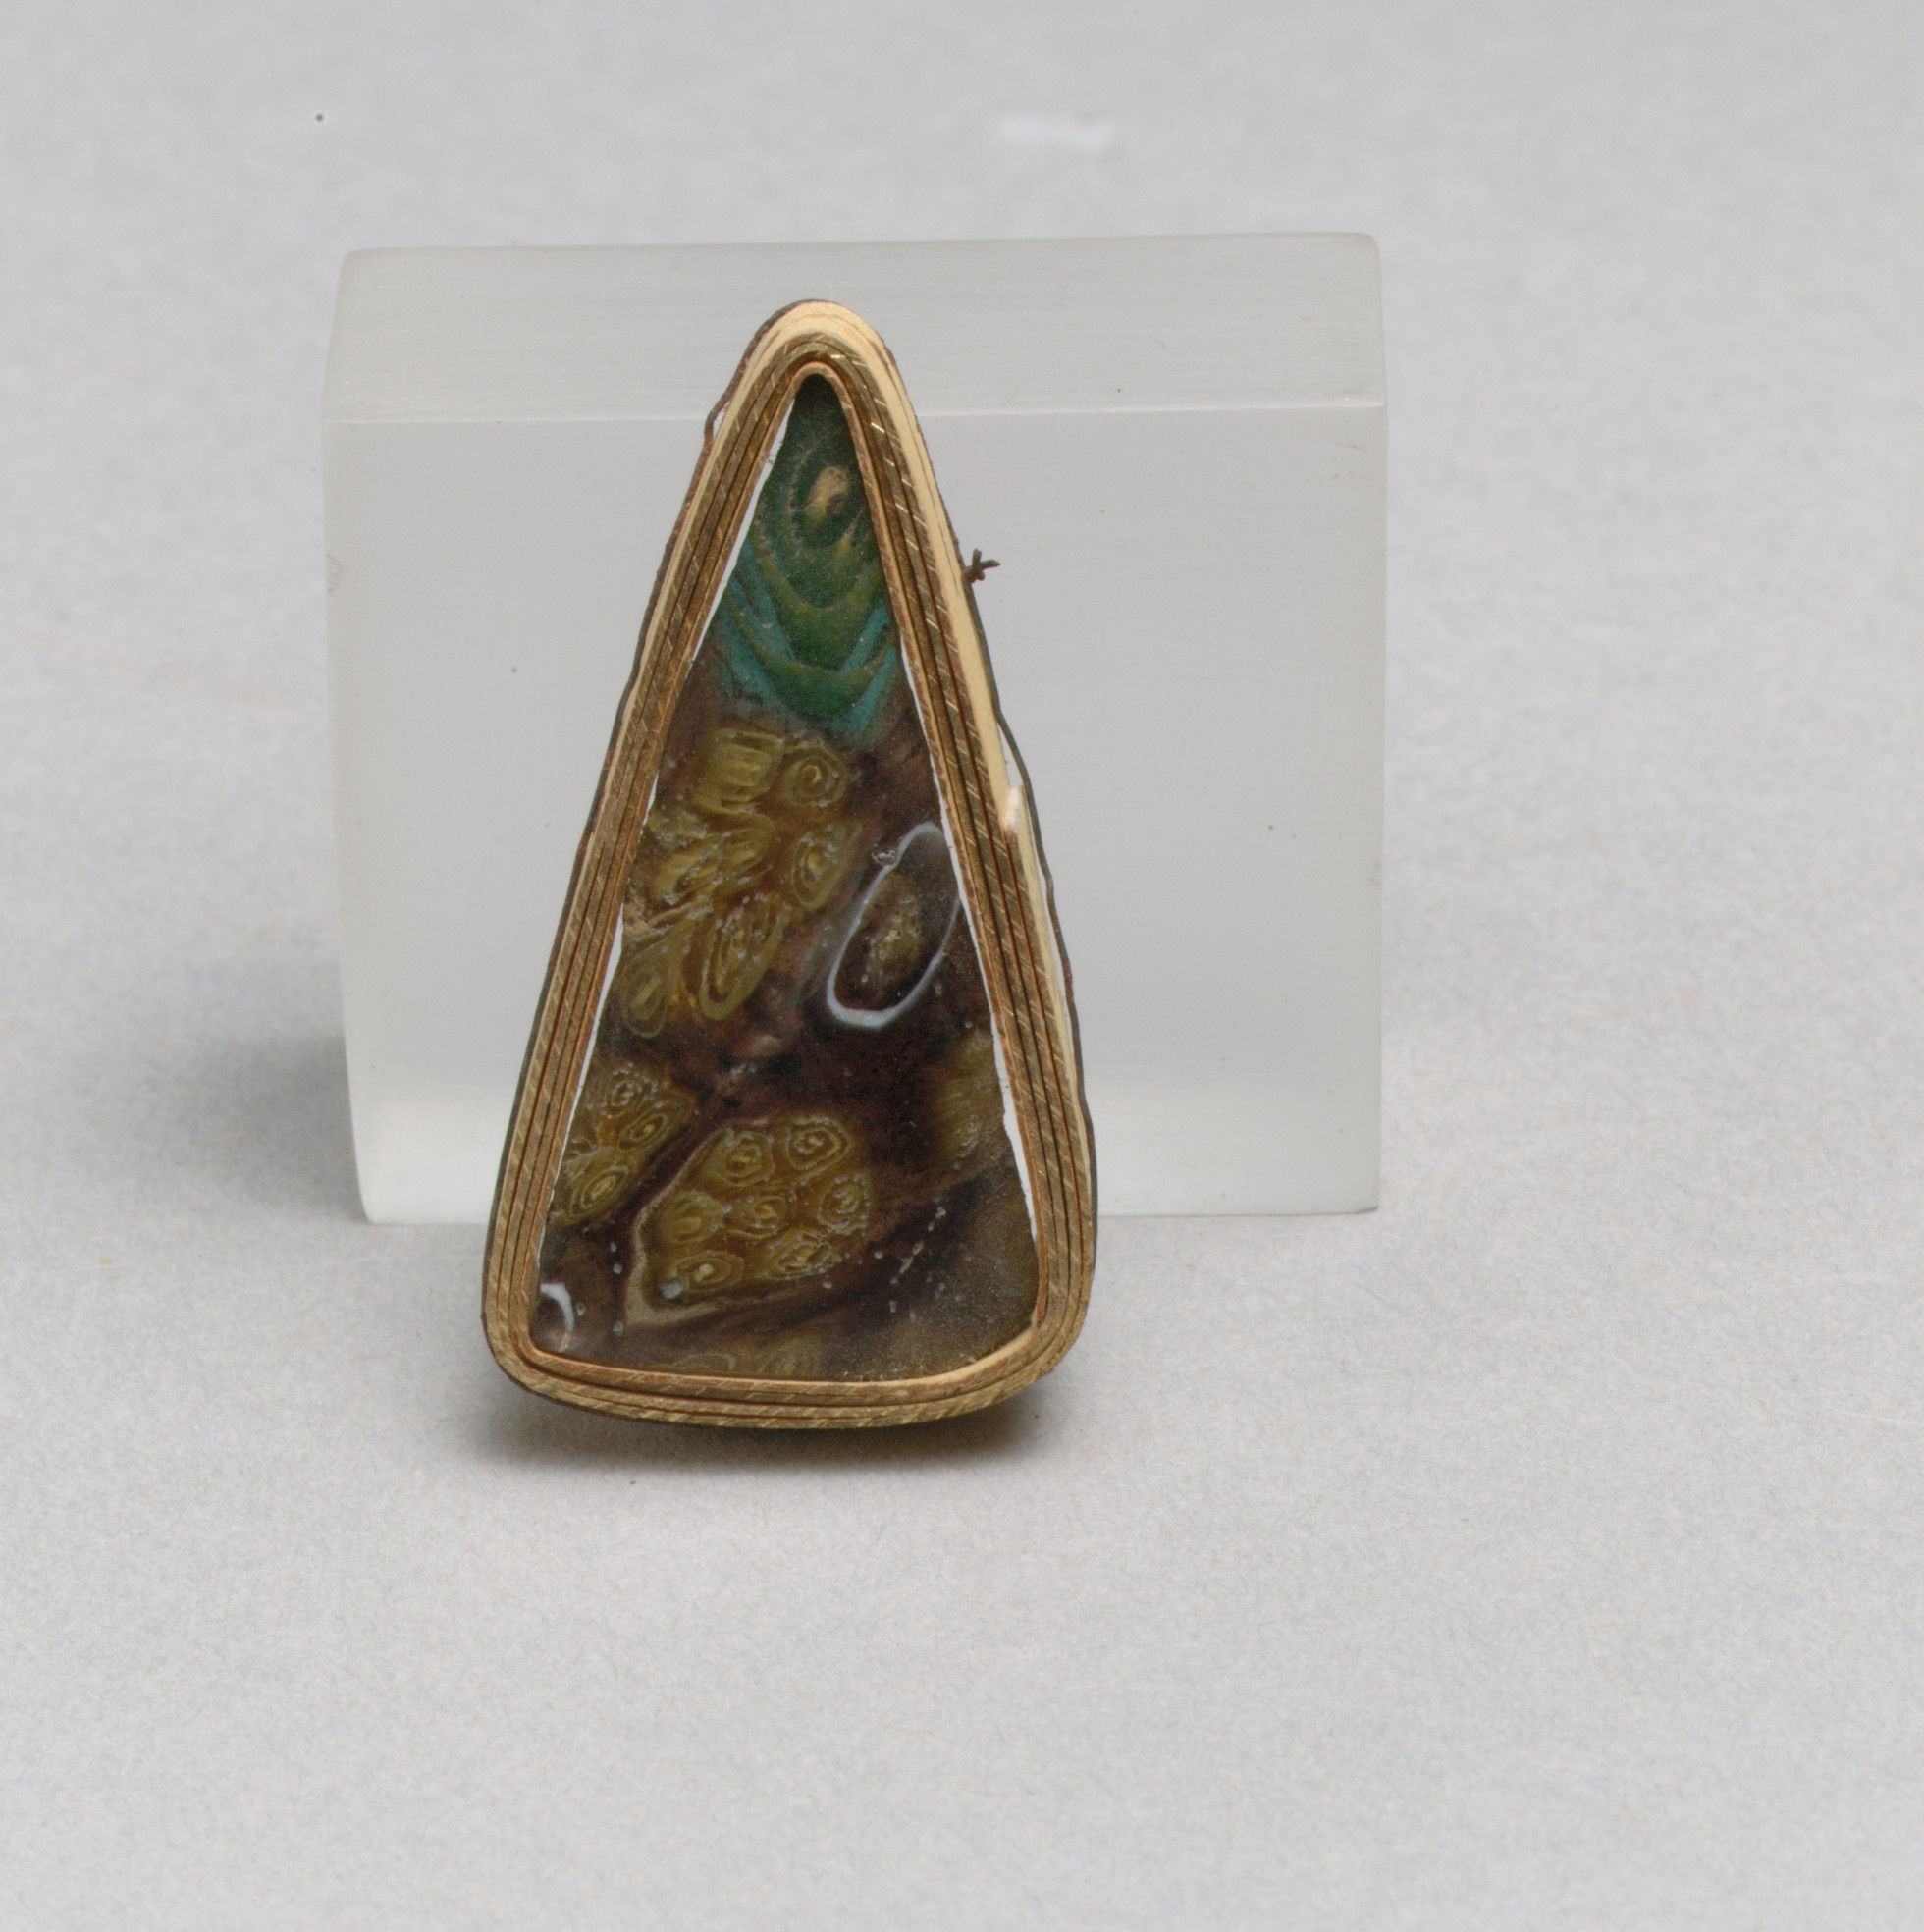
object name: fragment, mosaic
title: Glass mosaic fragment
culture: roman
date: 34 BCE-33 CE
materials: glass